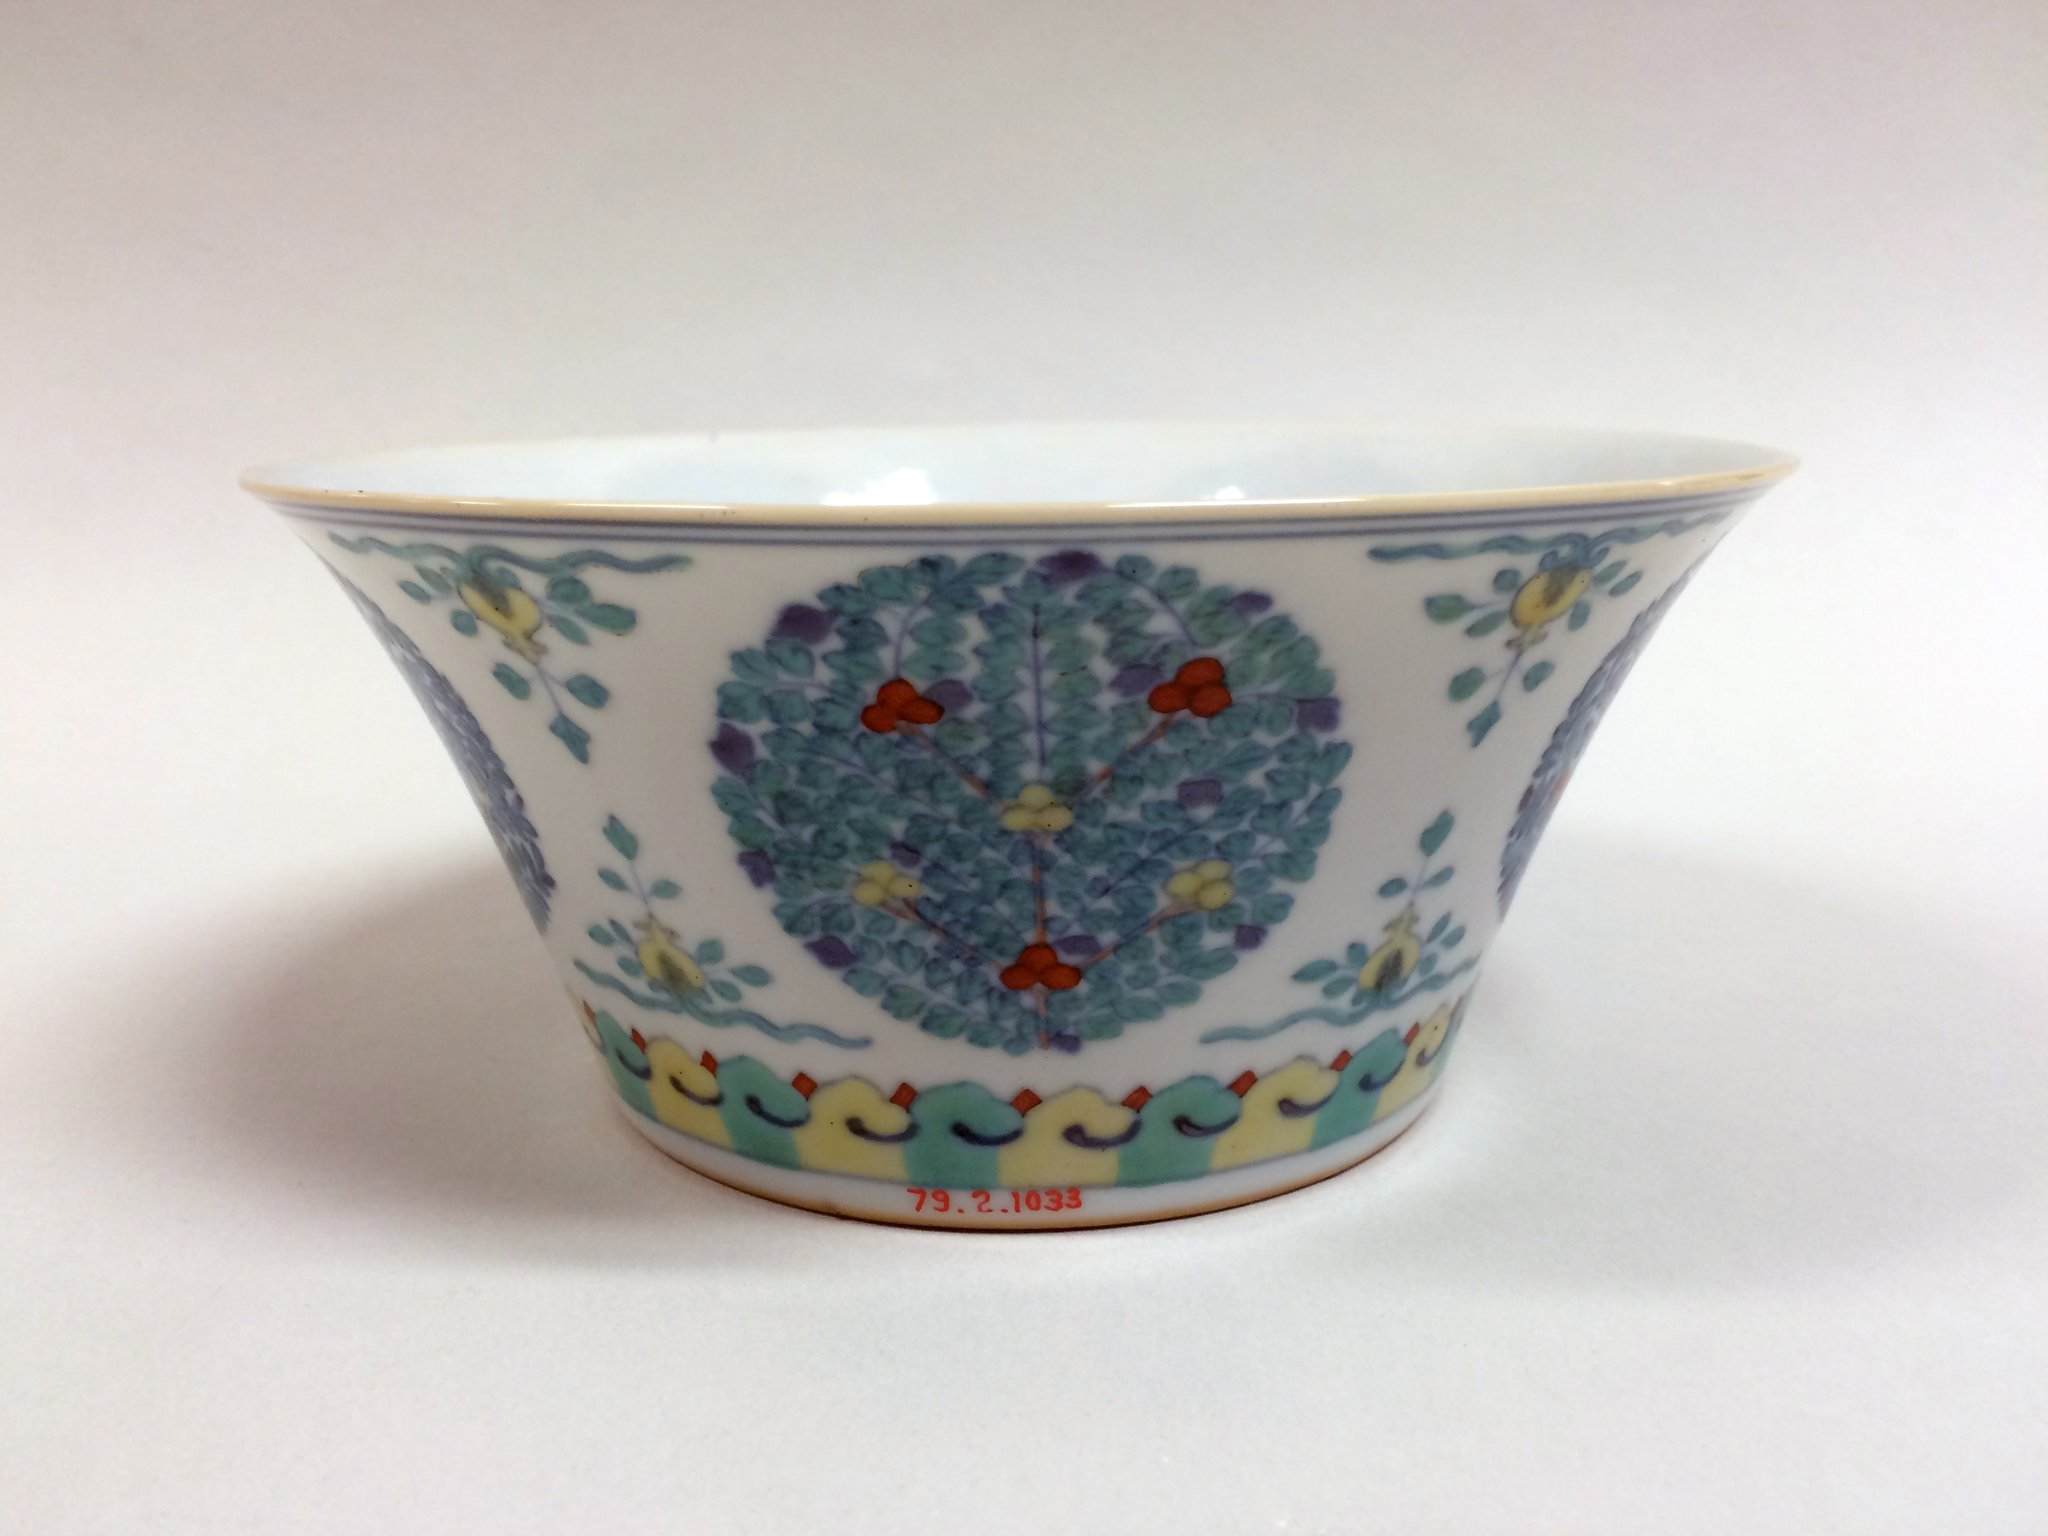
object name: bowl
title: Bowl with floral medallions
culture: chinese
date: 1801-1833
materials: cobalt, enamel, porcelain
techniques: overglaze, underglaze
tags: leaves